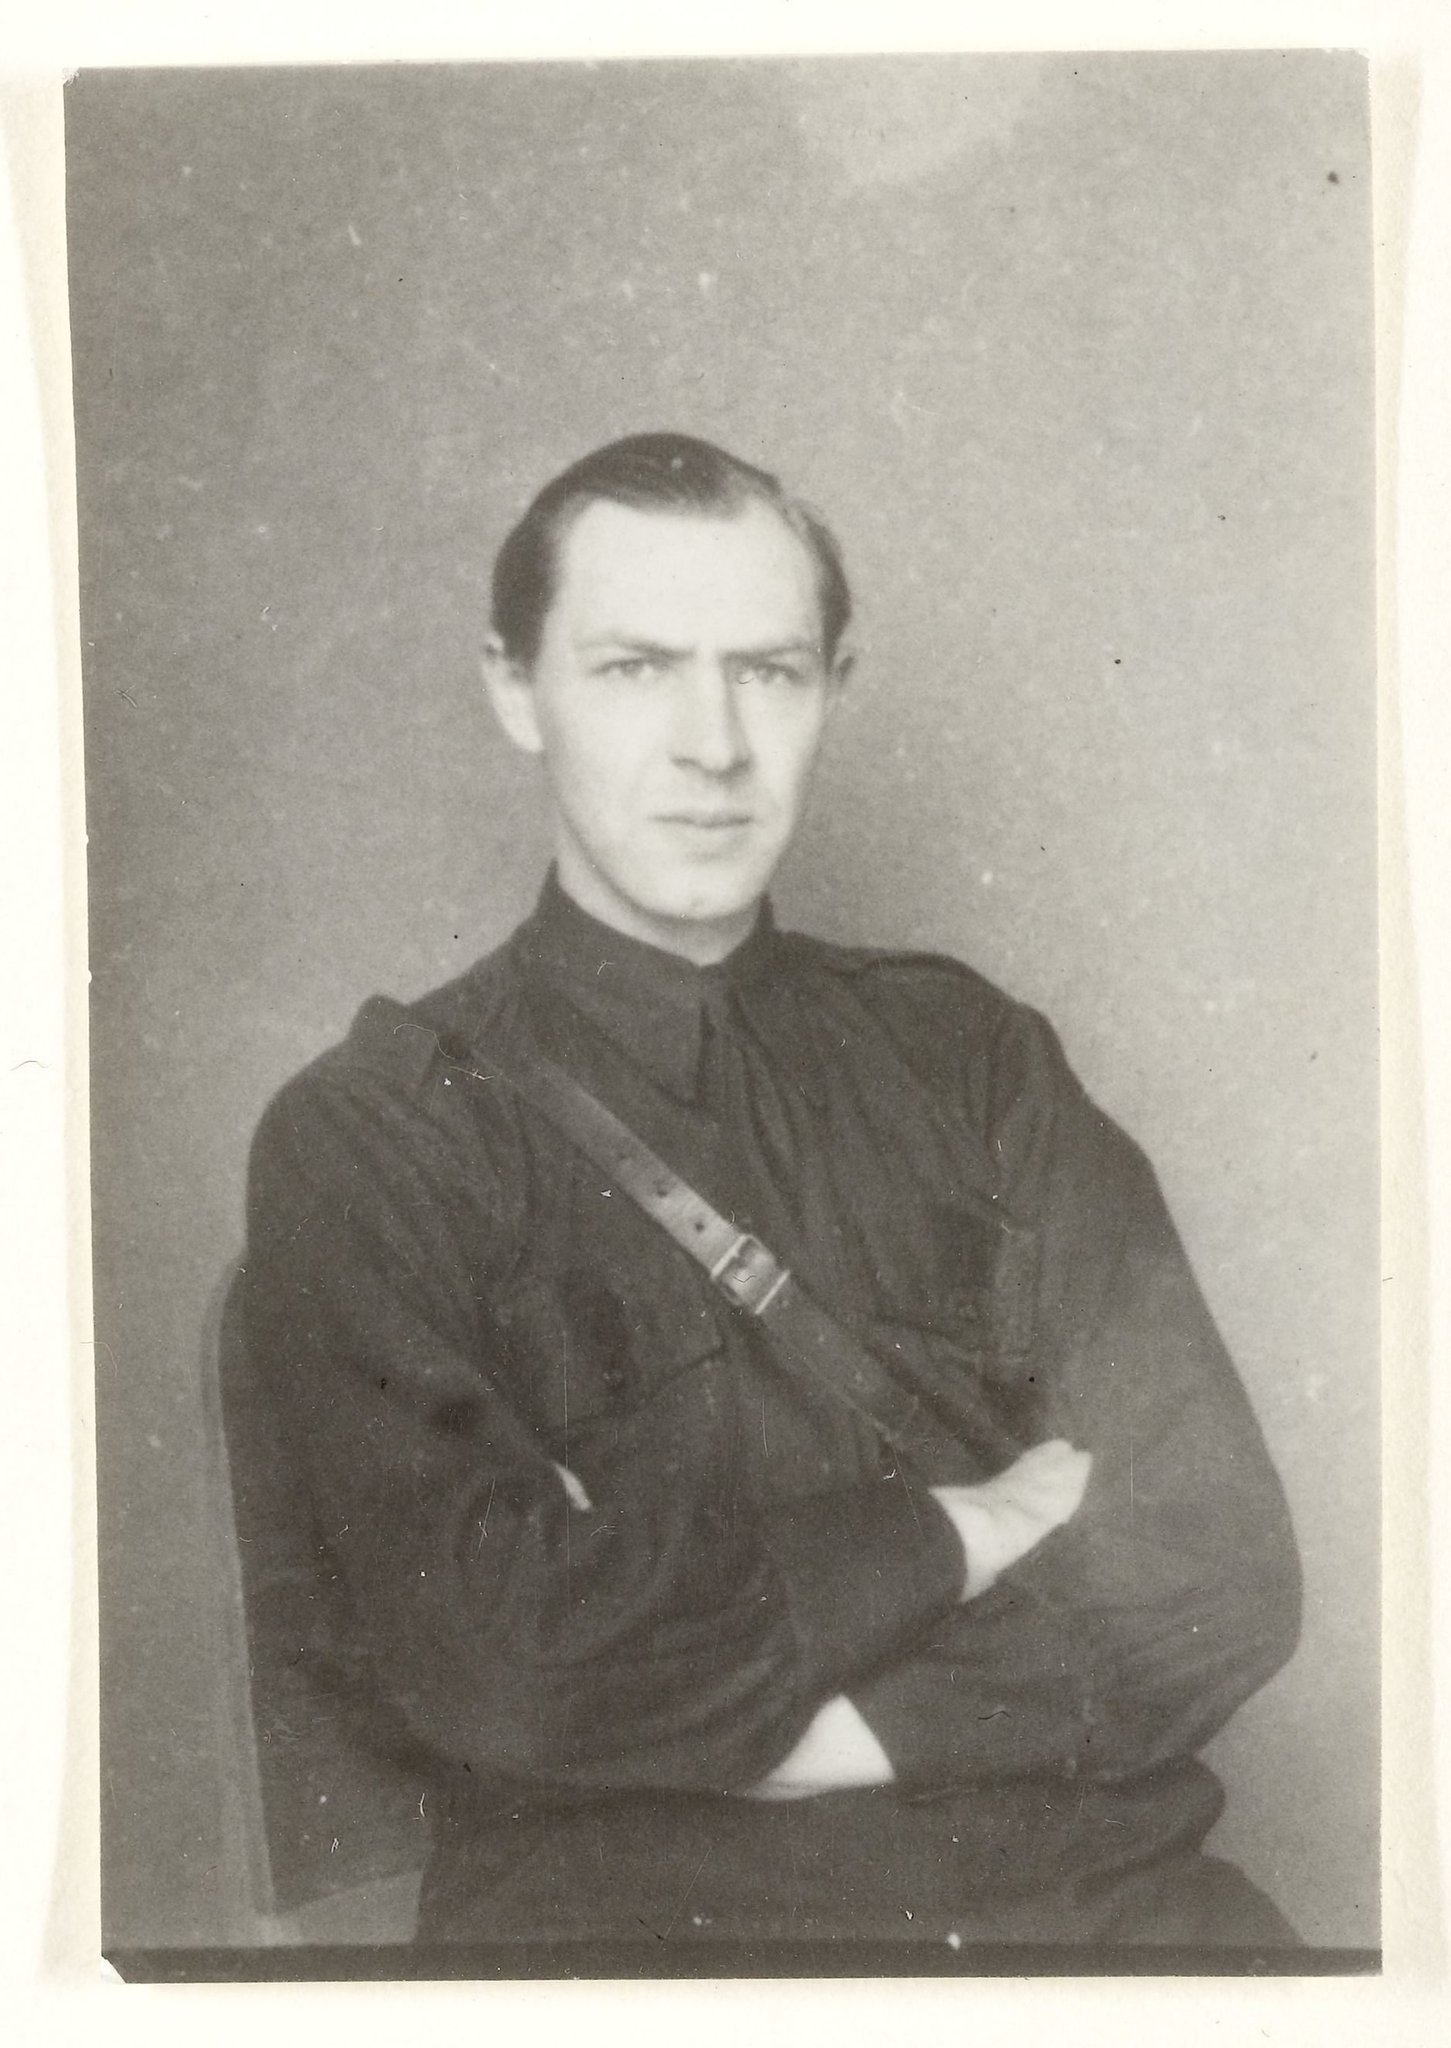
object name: photograph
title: Portret van een lid van de NSB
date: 1940-1944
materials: photographic support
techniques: photography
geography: netherlands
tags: anonymous historical person portrayed, netherlands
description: Portret van een lid van de NSB. Op zijn kraag een distinctief wat aangeeft dat hij een functie bekleed bij een van de Fronten of Gilden. Op zijn rechtermouw de driehoek in NSB kleuren met de letters NSB. Hij zit met de handen in elkaar. Blootshoofd.